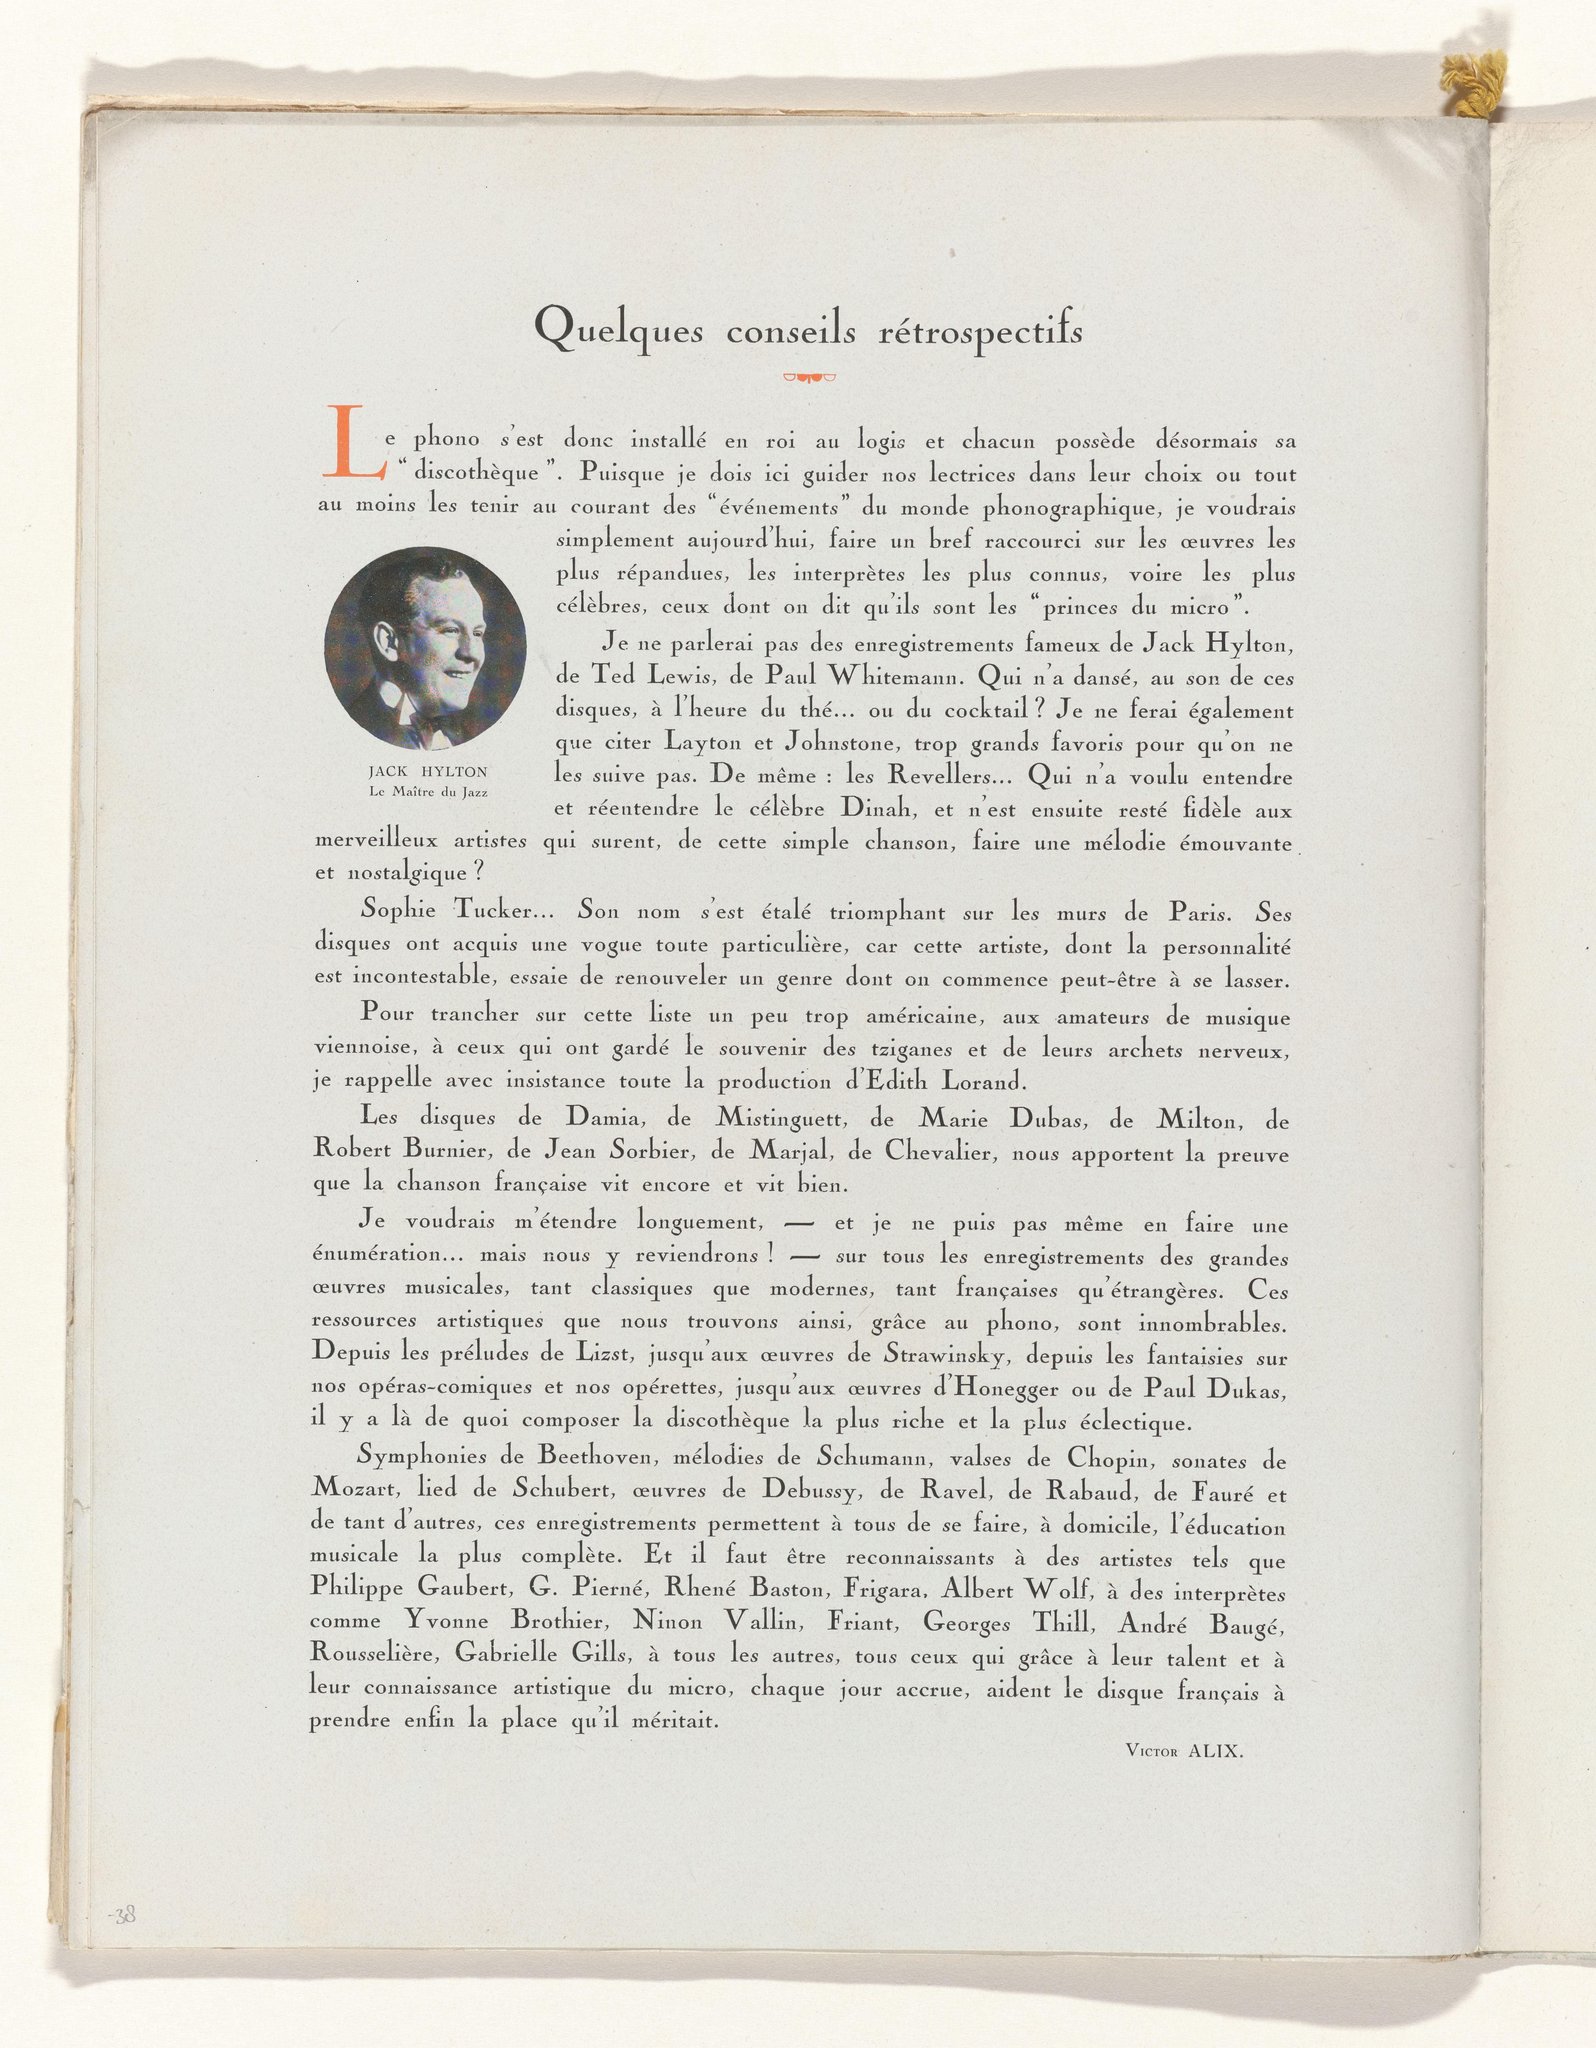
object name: fashion print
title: Art - Goût - Beauté, Feuillets de l' élégance féminine, Mai 1931, No. 129, 11e Année, p. 38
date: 1931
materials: paper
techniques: printing, photography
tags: fashion plates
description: Tekst 'Quelques conseils rétrospectifs' met een afbeelding van Jack Hylton, 'Le Maître du Jazz'.. Pagina uit het modetijdschrift Art-Goût-Beauté (1920-1933).